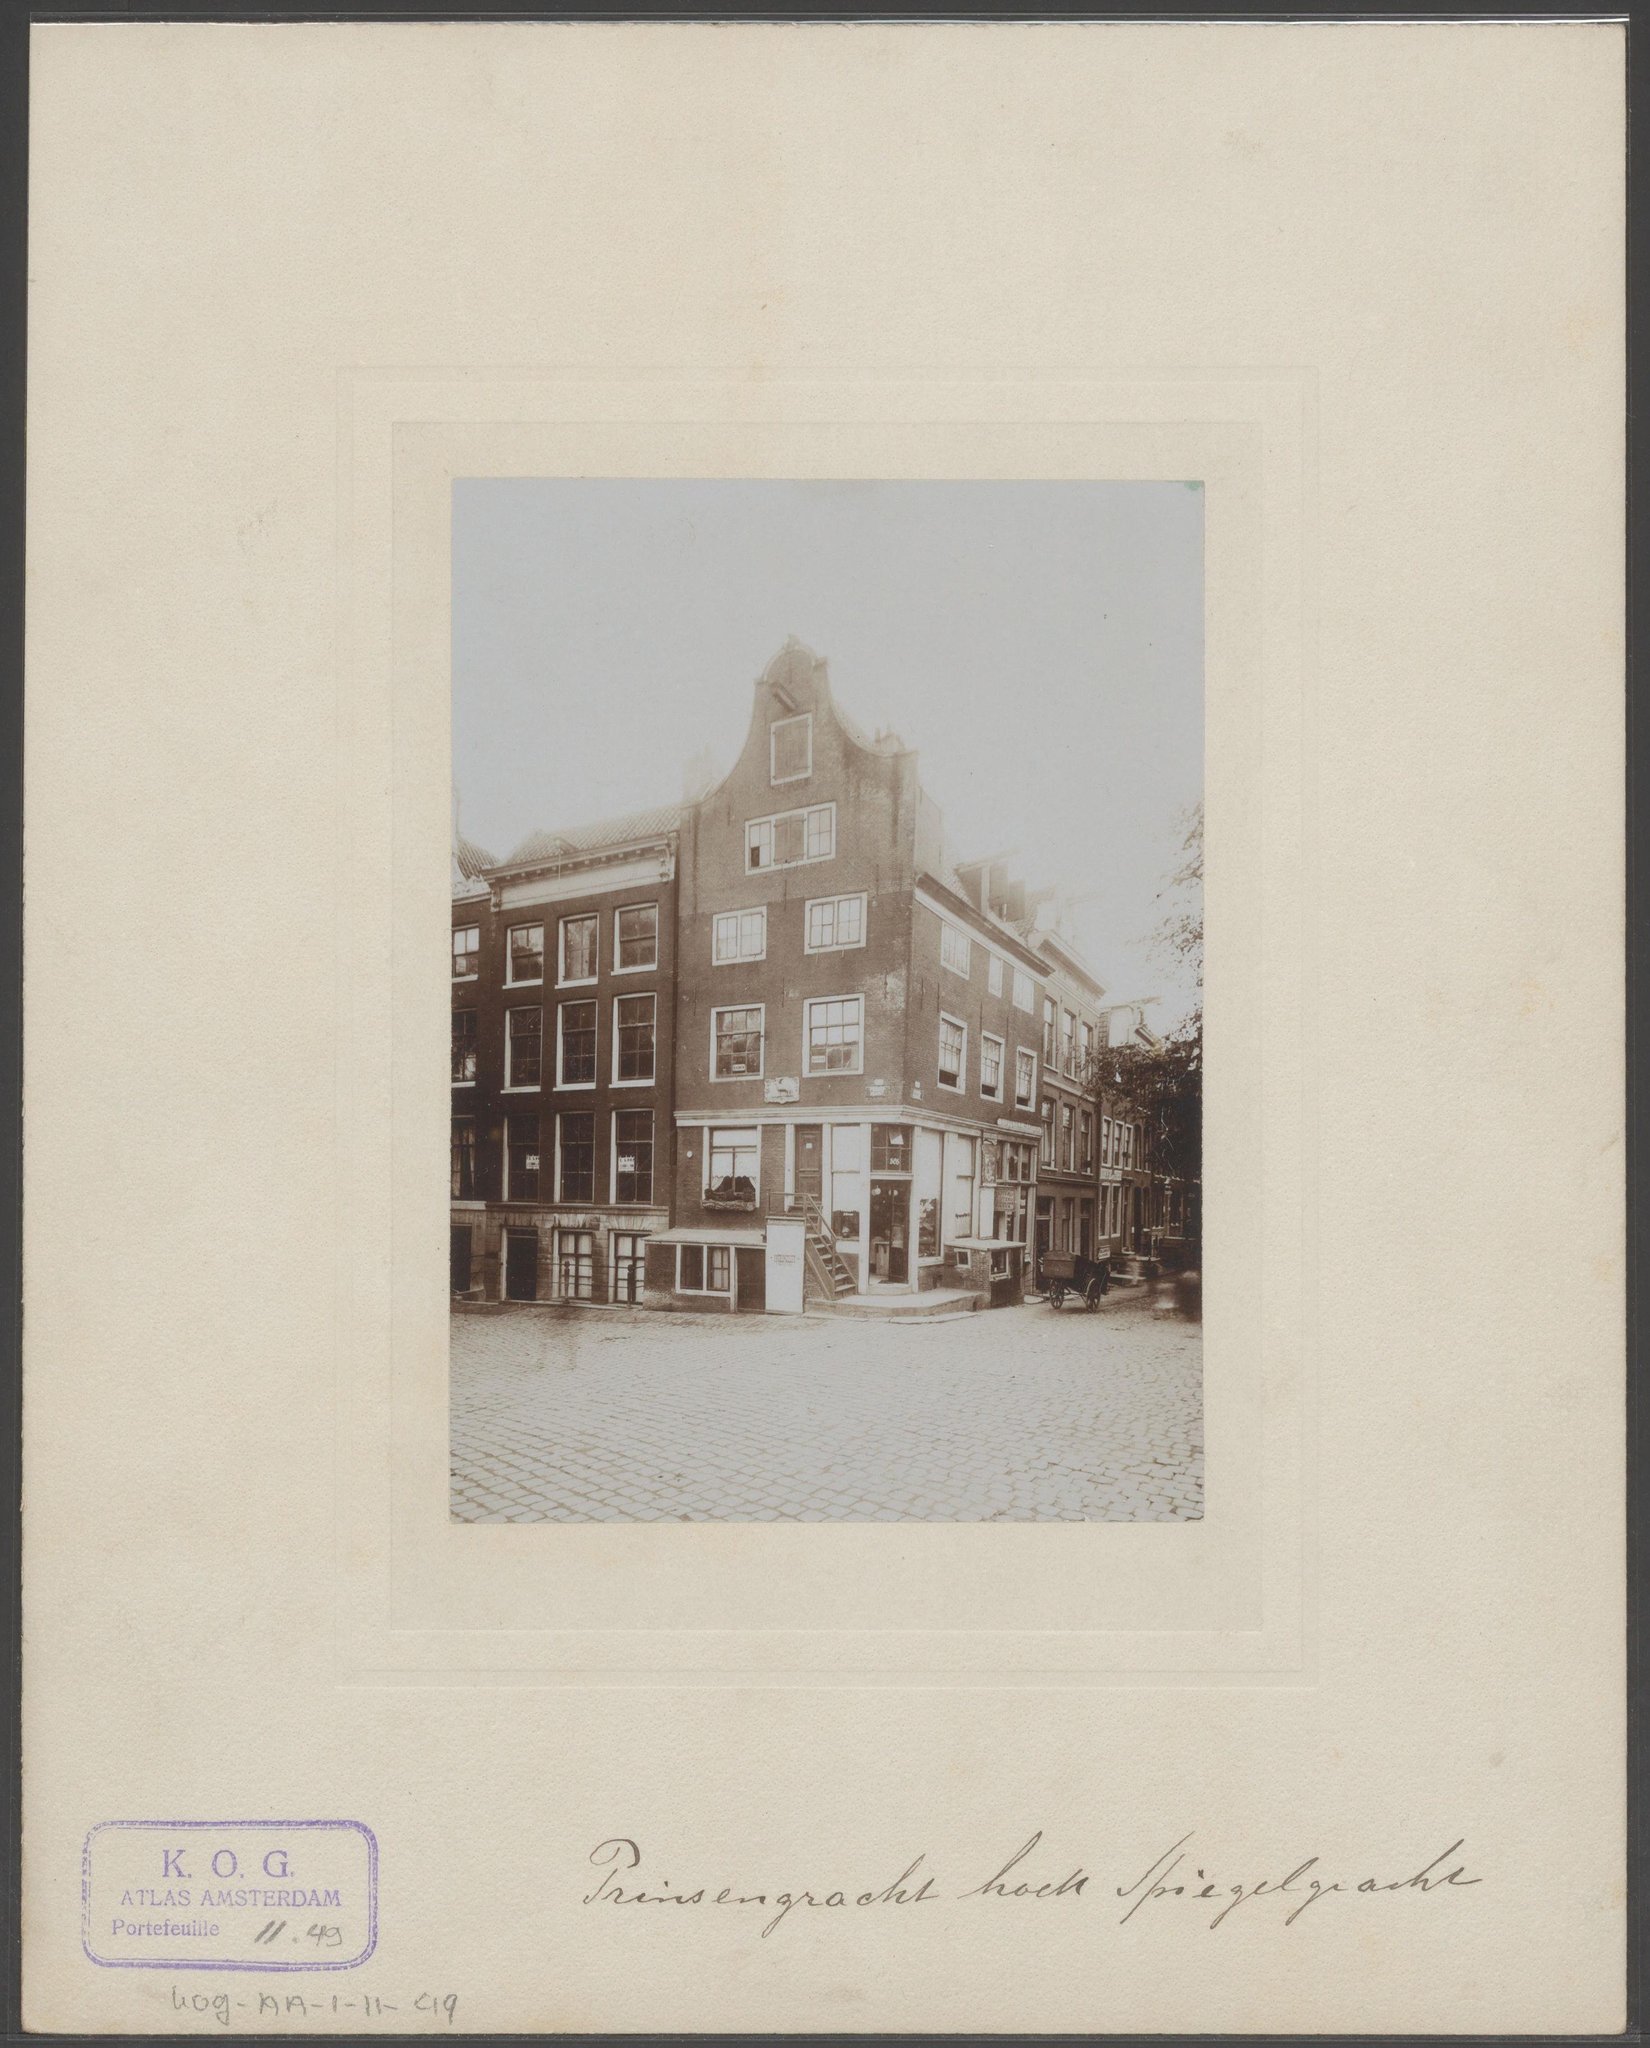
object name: photograph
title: Gezicht op de Prinsengracht, hoek Spiegelgracht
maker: Anonymous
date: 1865-1940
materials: paper, cardboard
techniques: collodion silver print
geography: amsterdam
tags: city-view in general; 'veduta', the usual house or row of houses, façade (of house or building), street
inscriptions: inscription: ‘Prinsengracht hoek Spiegelgracht’, collector's mark: ‘11.49’ Lugt 1641b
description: Onderwerpsrubriek binnen de Atlas Amsterdam: Prinsengracht, Korte Prinsengracht, Prins Hendrikkade. Zie ook Portefeuille 1: gezichten van het IJ op de stad.